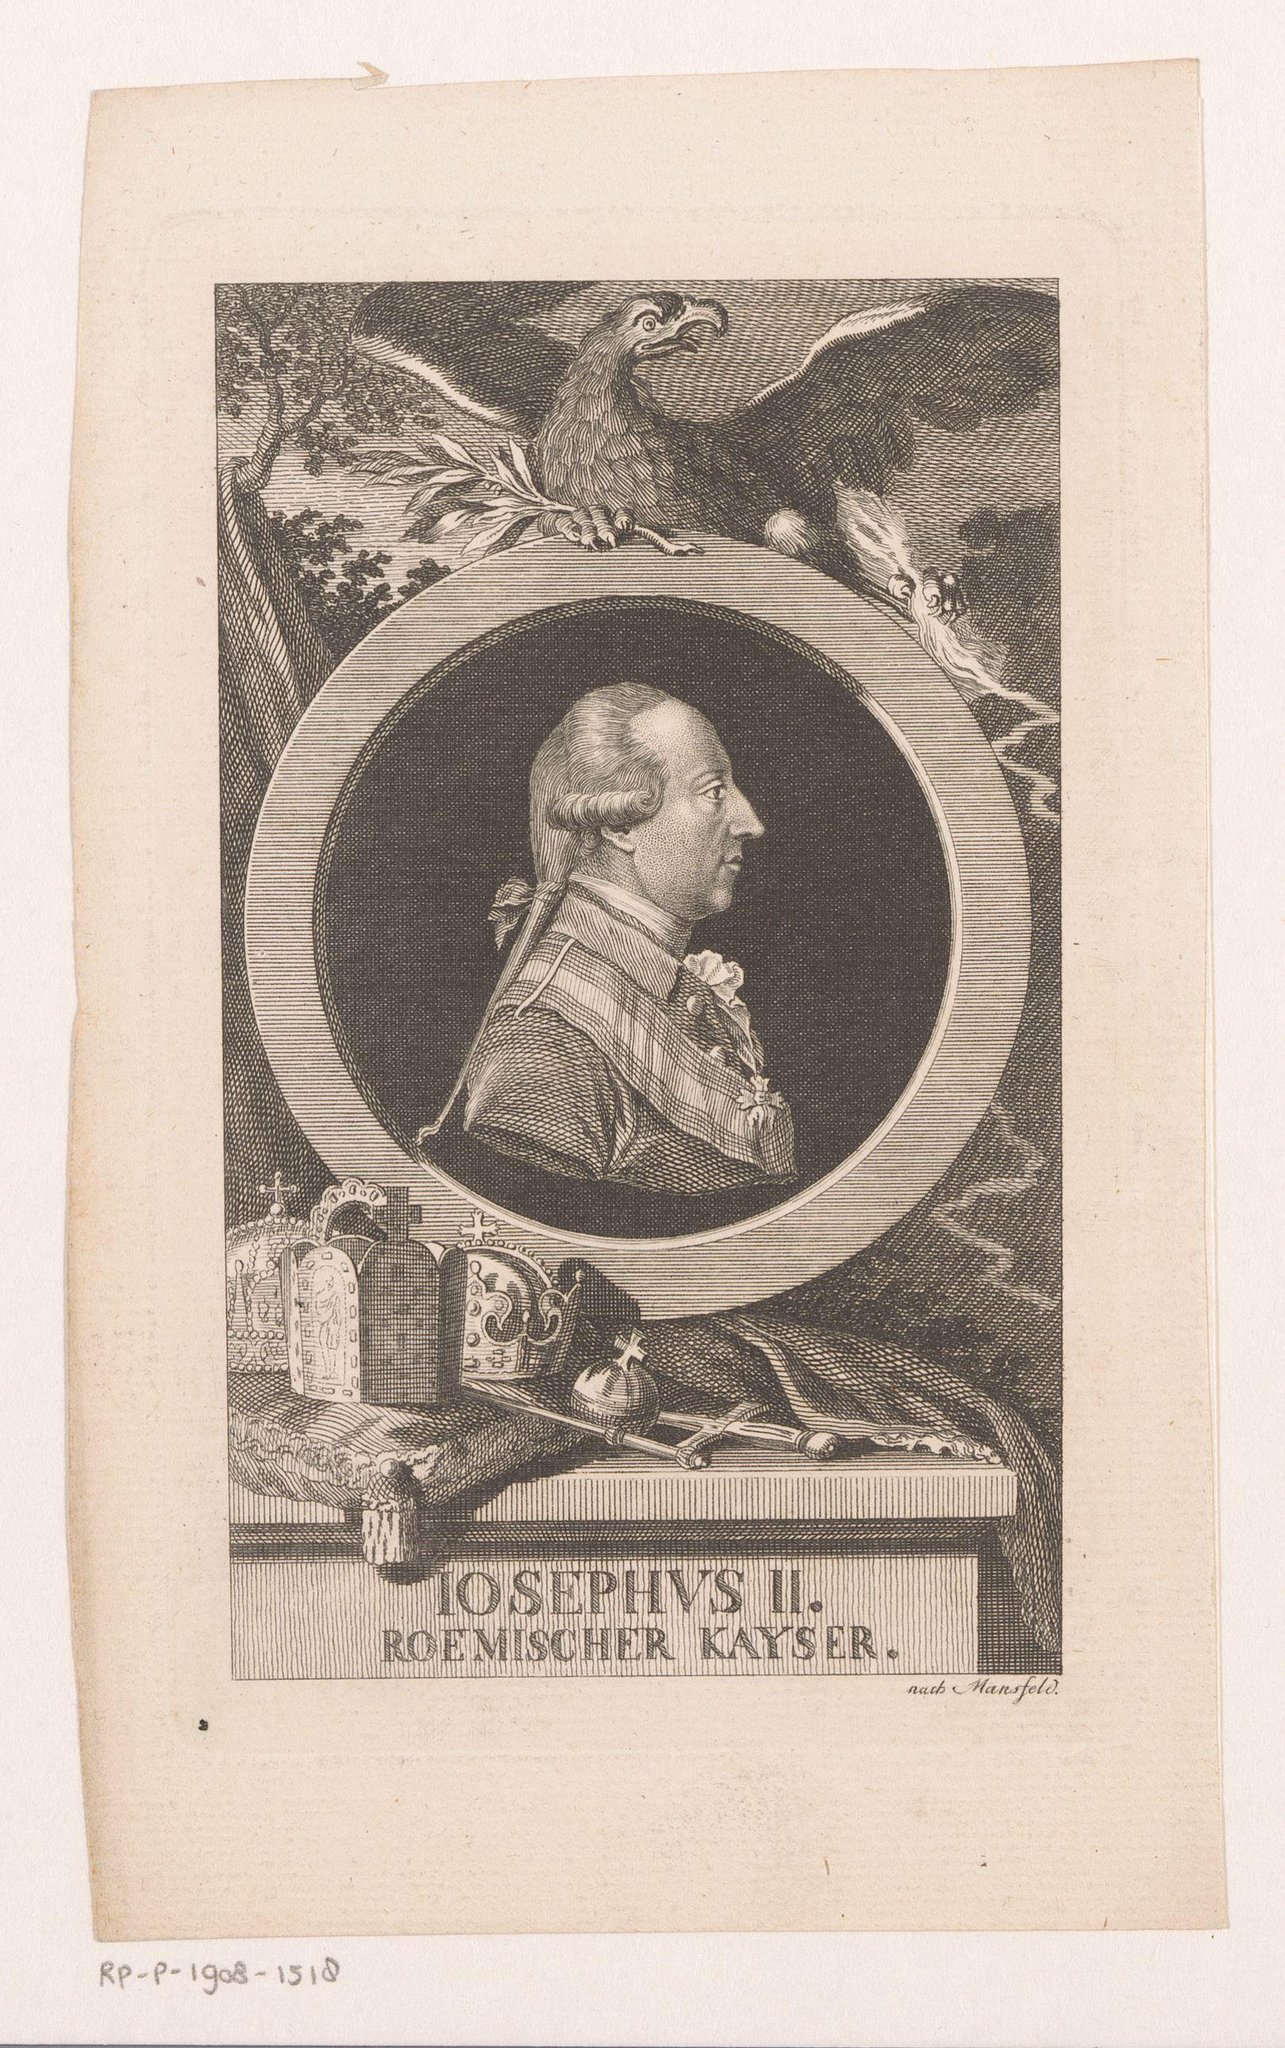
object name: print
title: Portret van keizer Jozef II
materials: paper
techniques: engraving, etching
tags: vienna, jozef ii (duits keizer), historical persons, insignia and symbols of sovereignty (crown, diadem, sceptre, orb, seal, standard, cloak, pectoral)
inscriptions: collector's mark: Lugt 2228